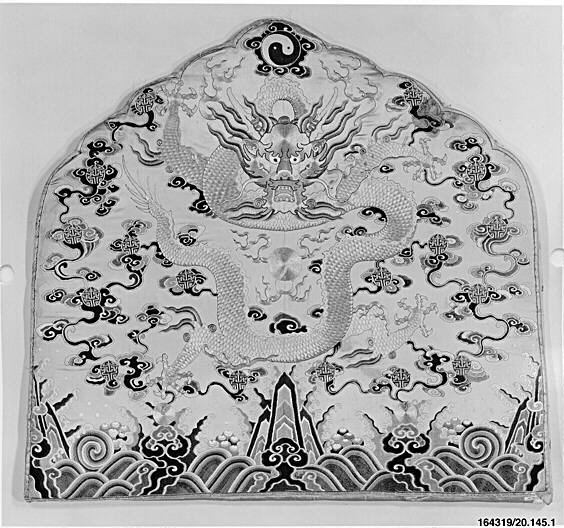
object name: cushion cover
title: Cushion Cover for Throne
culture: chinese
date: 1701-1800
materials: metal thread, silk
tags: dragons